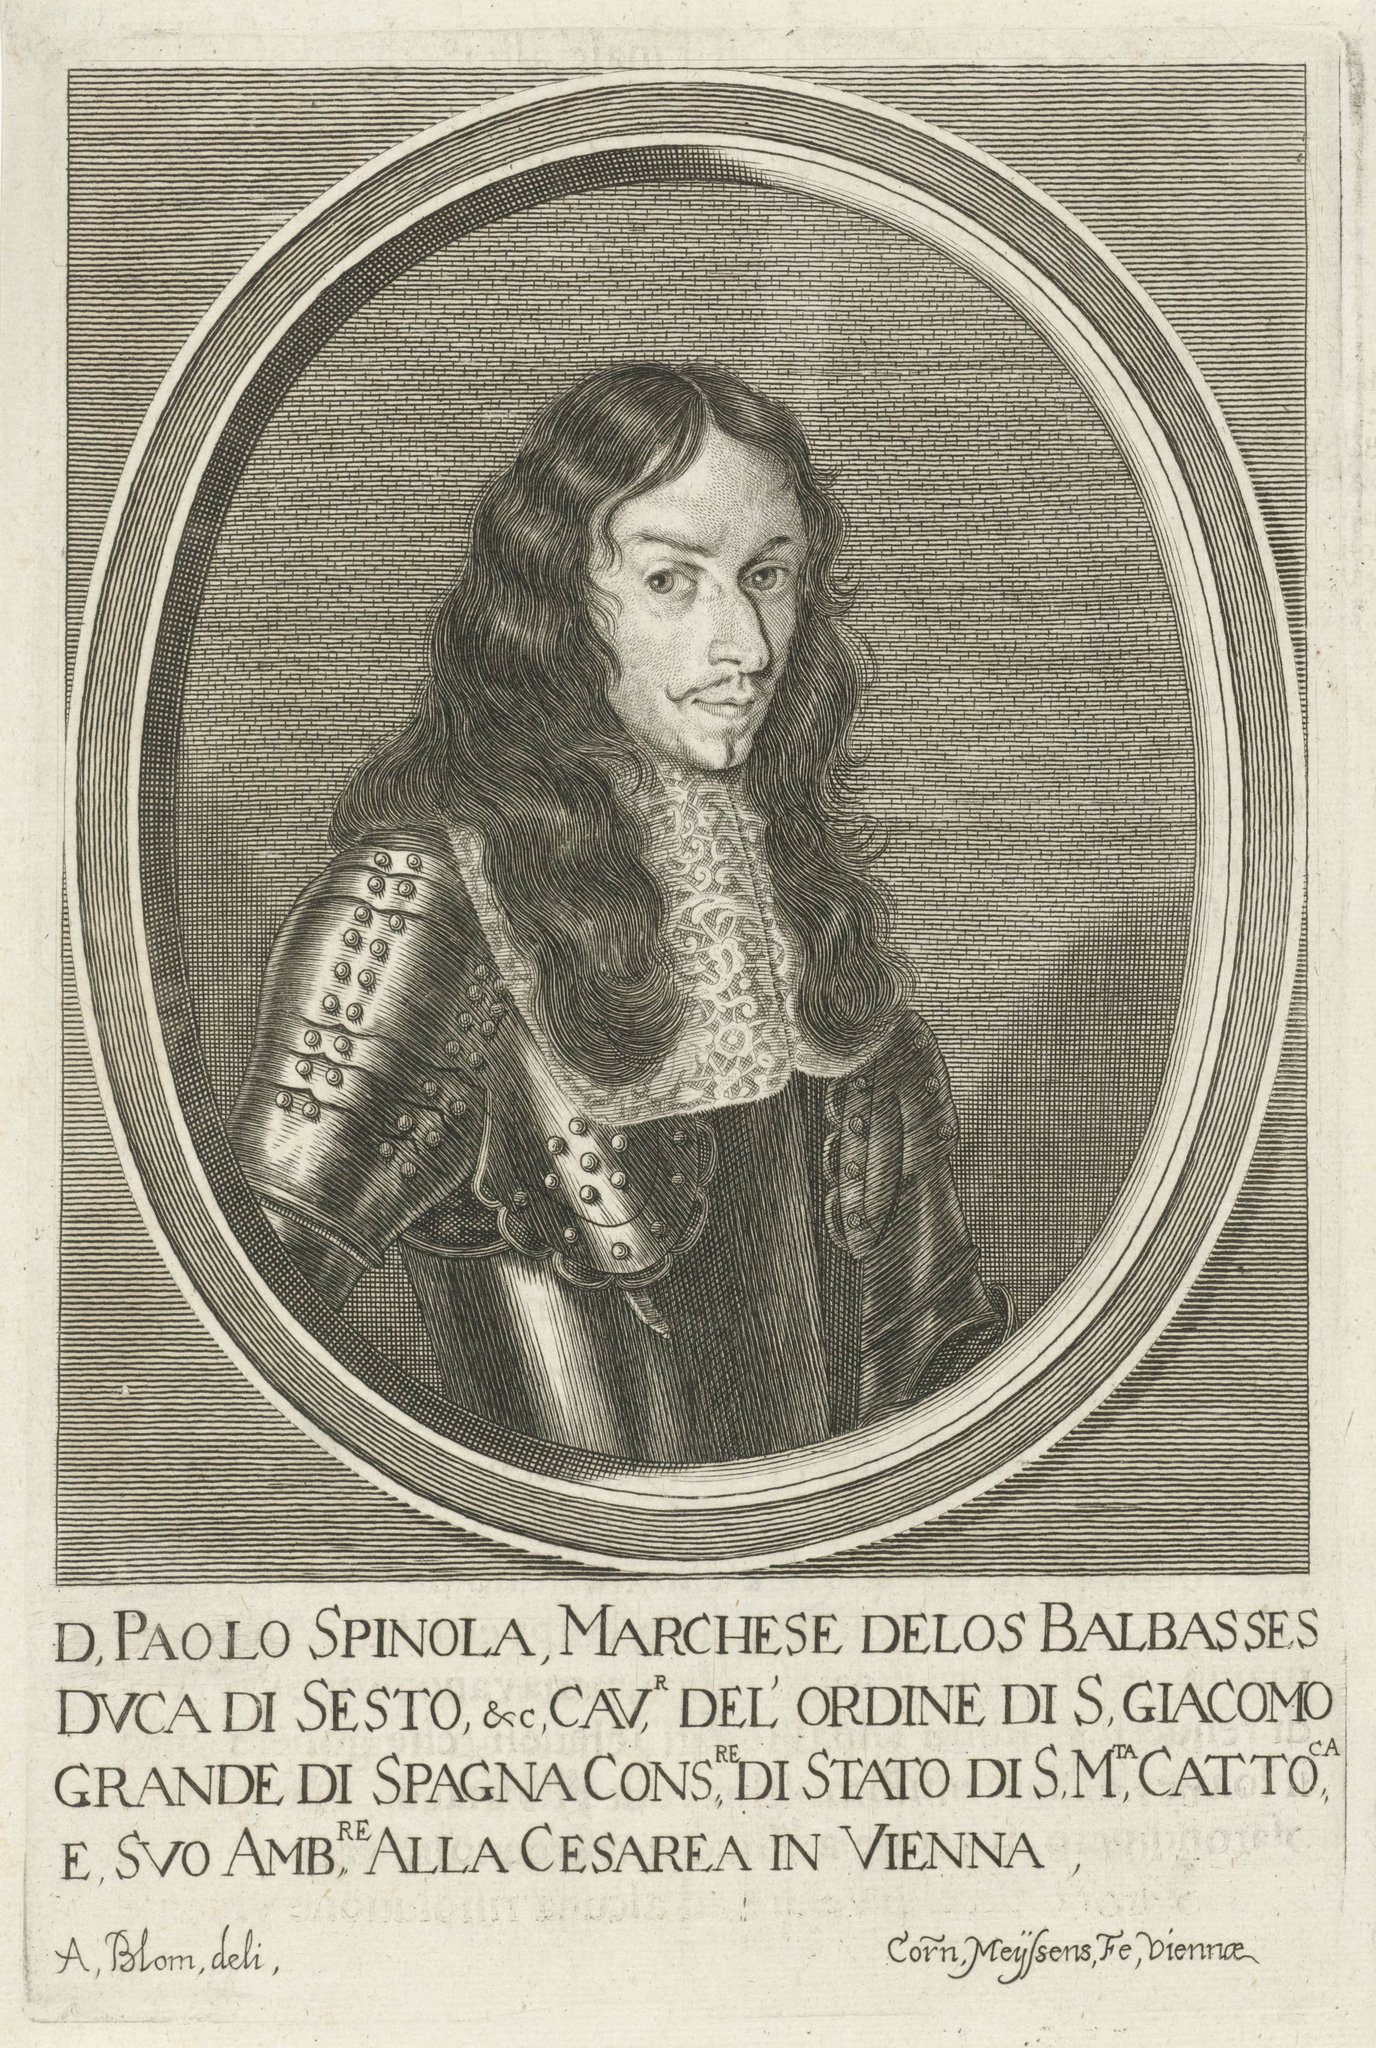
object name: print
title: Portret van Paolo Spinola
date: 1670-1674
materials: paper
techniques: engraving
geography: vienna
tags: ambassadeur, gouverneur, paolo spinola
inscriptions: collector's mark: Lugt 2228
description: Prent mogelijk gebruikt in: Gualdo Priorato, Galeazzo. Historia di Leopoldo Cesare, (...). 3 dln. Wenen, Giovanni Battista Hacque, 1670-1674.